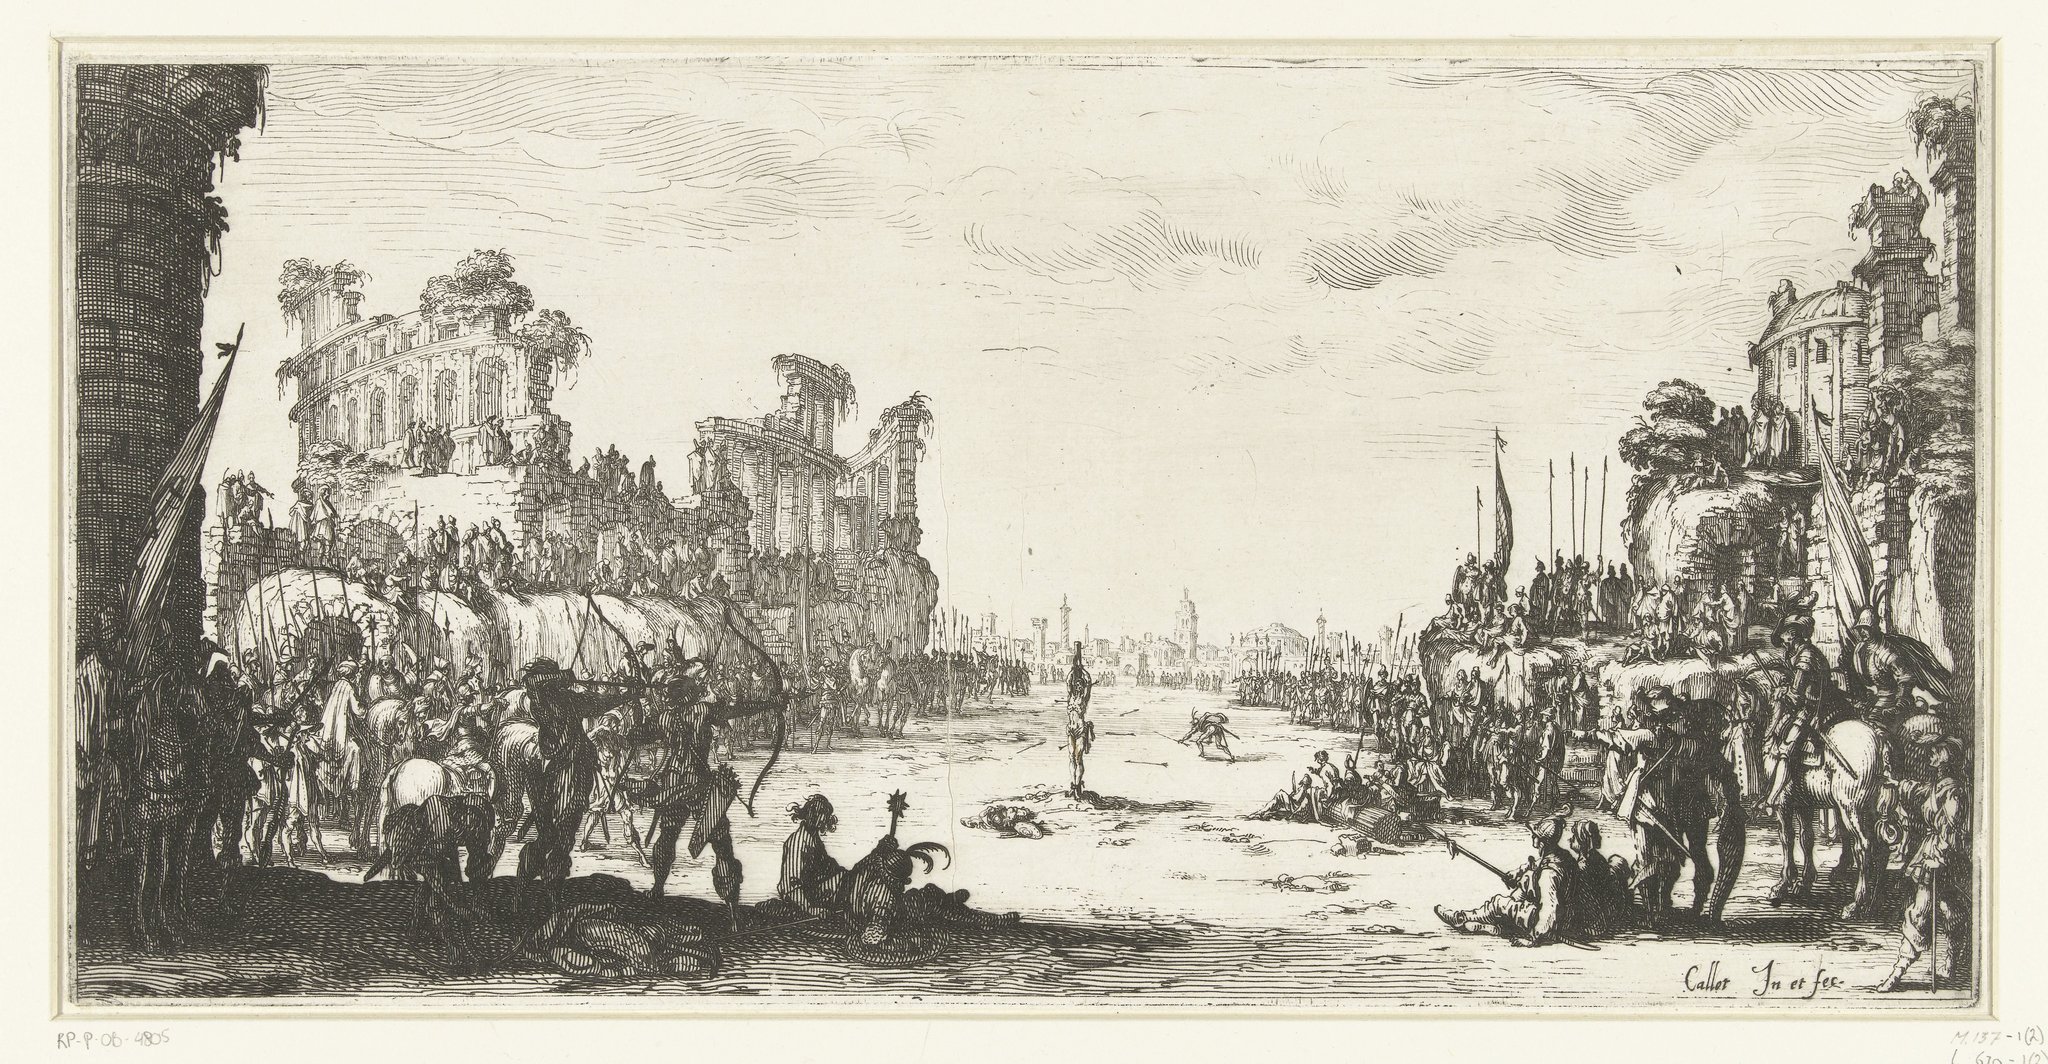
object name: print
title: Het martelaarschap van de Heilige Sebastiaan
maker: jacques callot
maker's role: draughtsman, print maker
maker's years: 1592-1635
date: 1631-1633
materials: paper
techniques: etching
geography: nancy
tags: st. sebastian, tied to a tree or a pillar, is pierced by arrows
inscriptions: collector's mark: Lugt 240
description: Onder de belangstelling van een grote menigte wordt de Heilige Sebastiaan op een vlakte bij een stad (Rome) naast een vervallen amfitheater (Colosseum) door boogschutters beschoten.